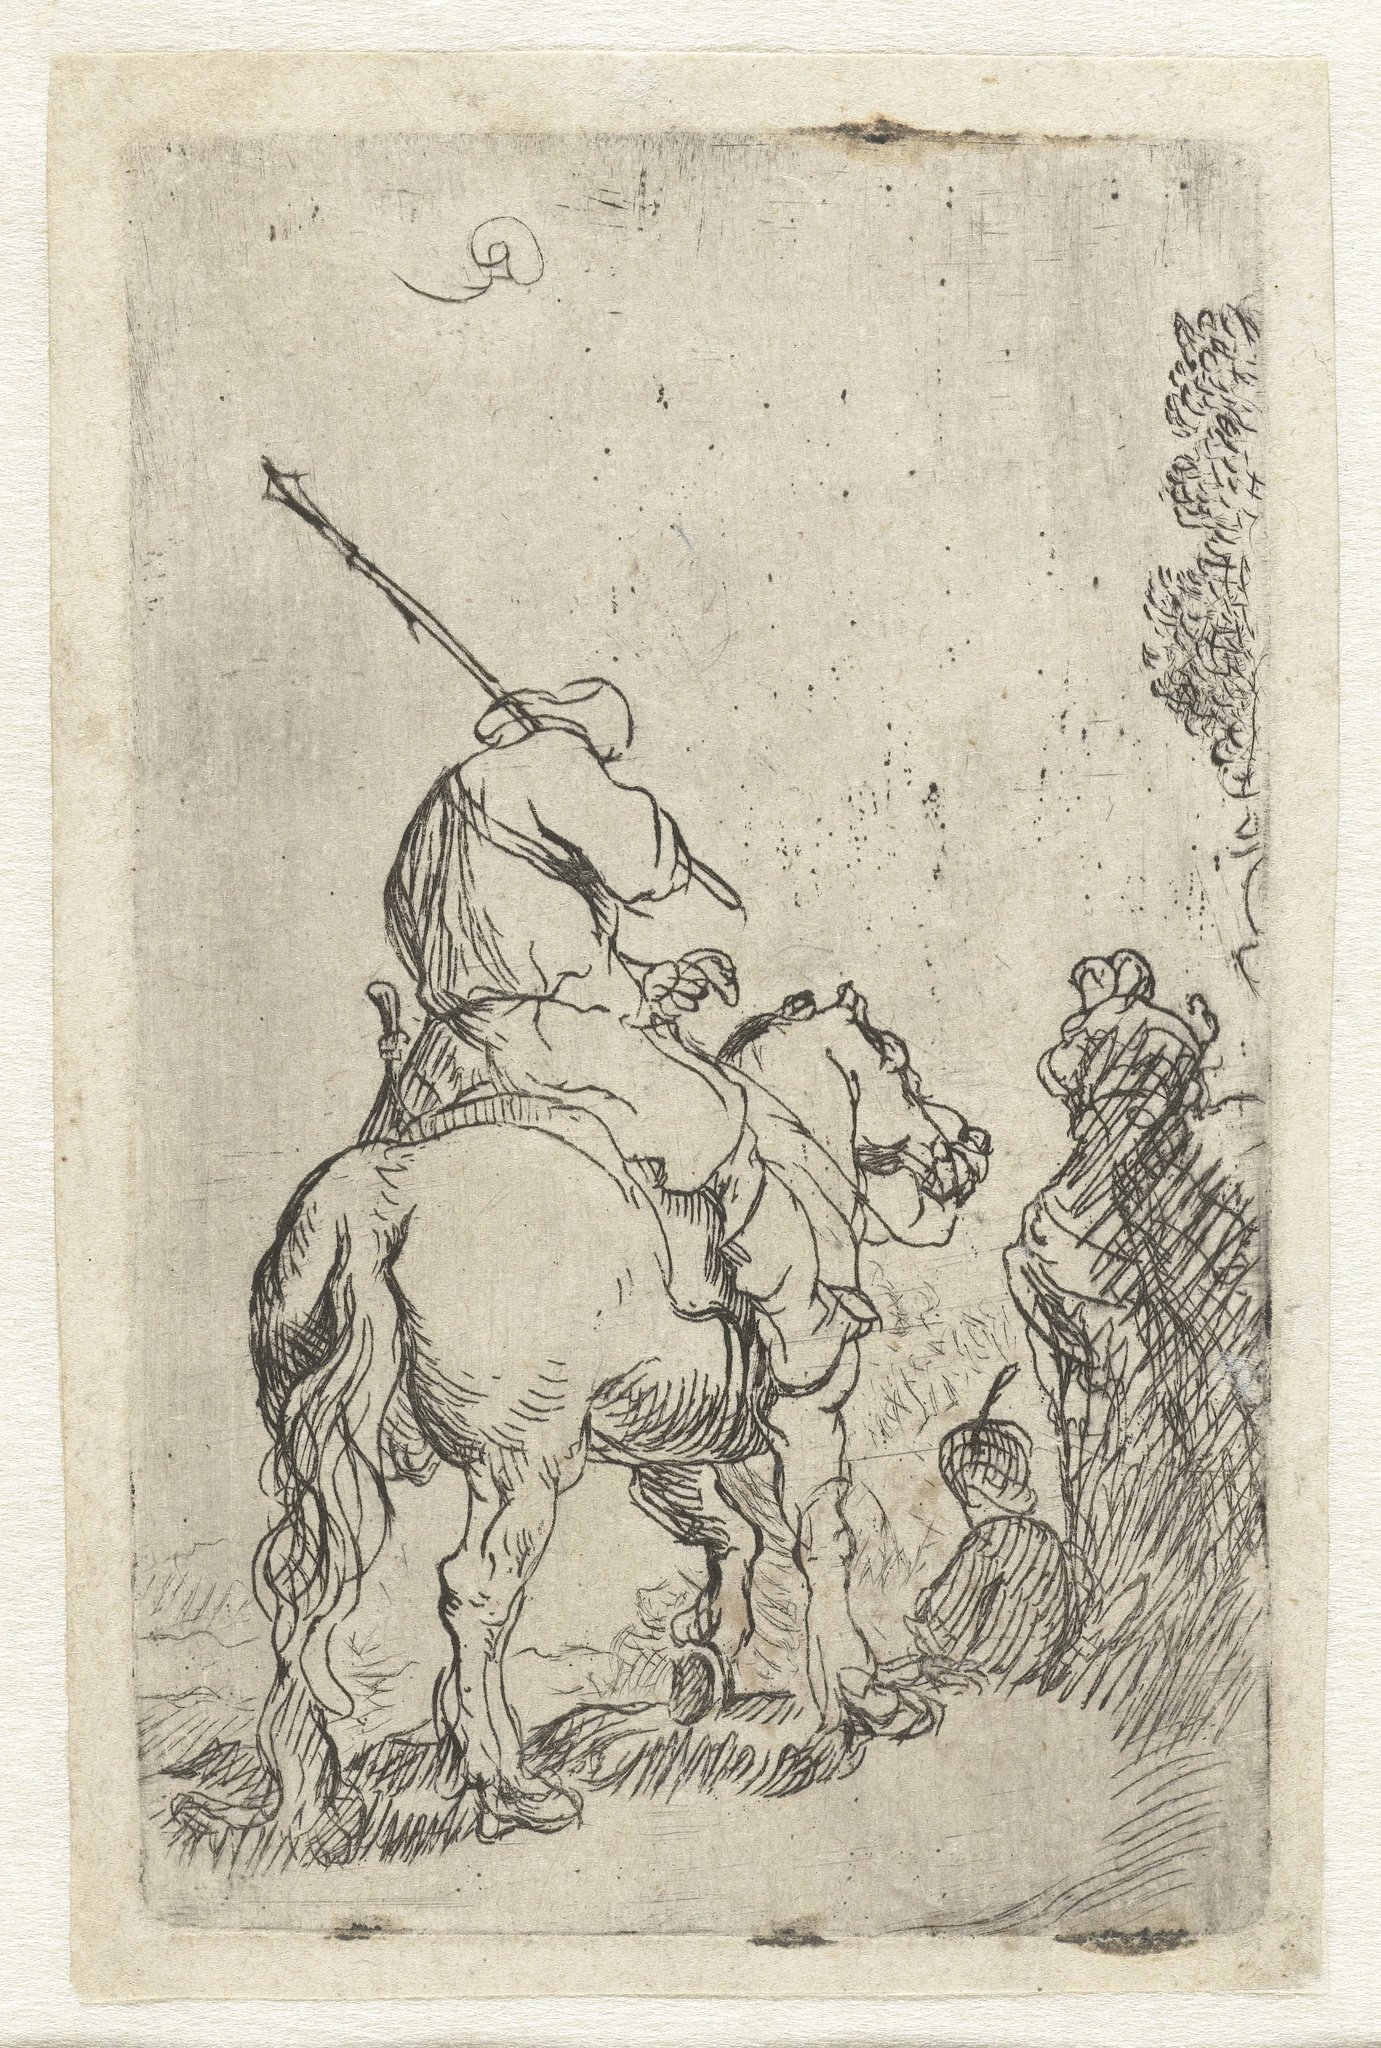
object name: print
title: Turbaned soldier on horseback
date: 1632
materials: paper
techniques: etching, intaglio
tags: riding a horse, ass, or mule; rider, horseman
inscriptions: collector's mark: Lugt 240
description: Spiegelbeeldige kopie naar de gelijknamige prent van Rembrandt.